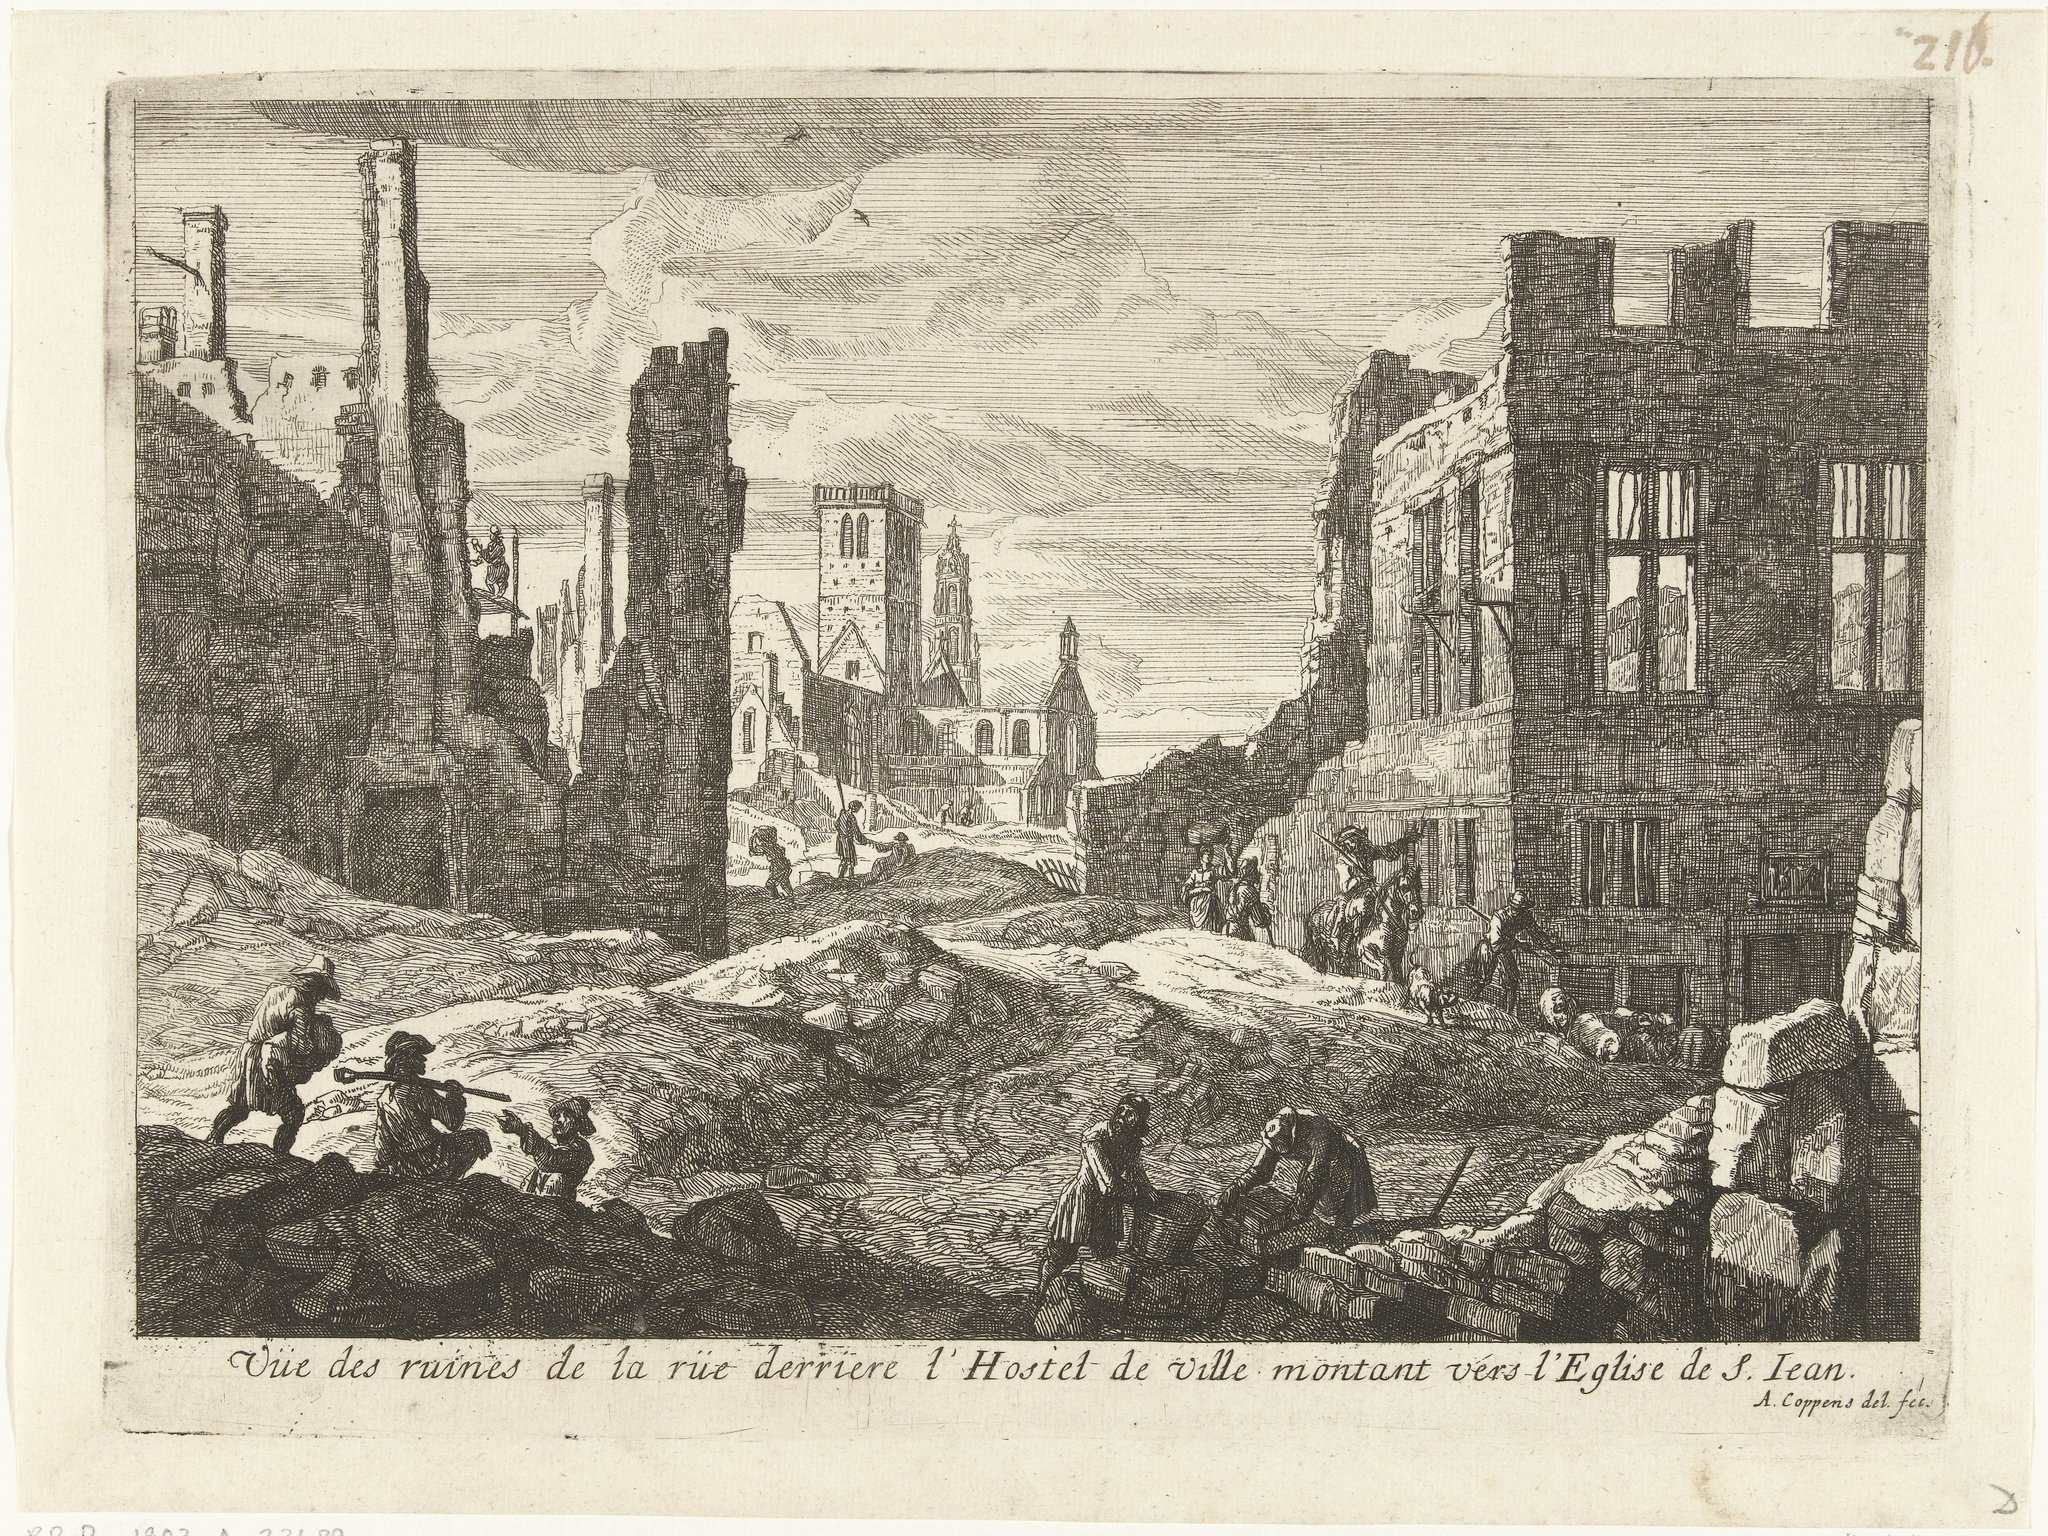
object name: print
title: Vue des ruines de la rue derriere l' Hostel de ville montant vers l'Eglise de S. Jean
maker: augustin coppens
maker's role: print maker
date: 1695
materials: paper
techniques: etching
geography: brussels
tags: devastated, ruined place or city (~ warfare), brussels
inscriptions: collector's mark: Lugt 2228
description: Voorstelling van de ruïnes achter het stadhuis tot aan de Sint Jan te Brussel na het bombardement door de Fransen, 13-15 augustus 1695. Tiende prent in de reeks van twaalf.